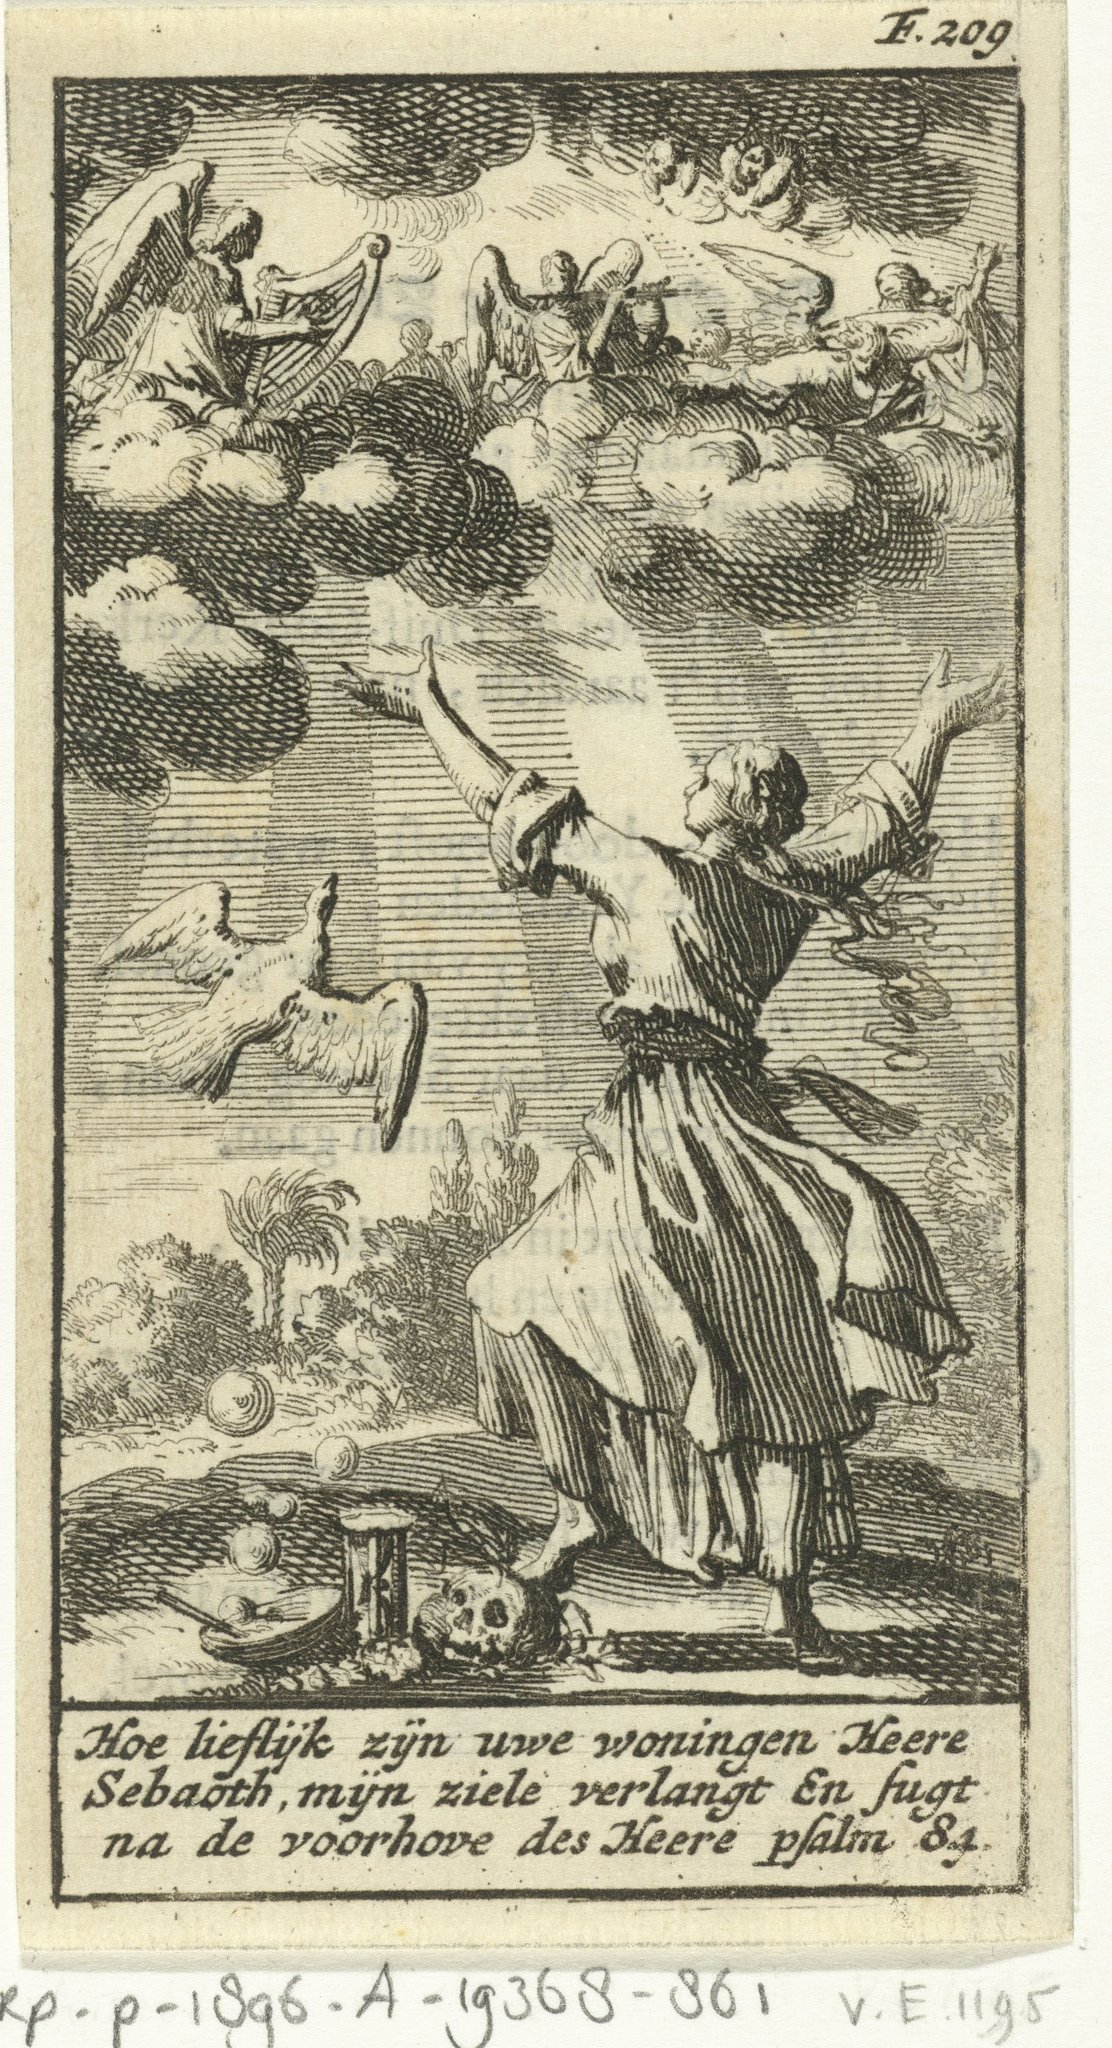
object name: book illustration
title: De Geheiligde Ziele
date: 1691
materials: paper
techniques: etching, letterpress printing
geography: amsterdam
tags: angels singing, making music, 'vanitas' symbols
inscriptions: collector's mark: Lugt 2228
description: Illustratie uit: Hakvoord, Barend. Het heilige avondmaal, van onzen Heer en Zaligmaker Jesus Christus. Amsterdam: Gijsbert de Groot, 1691.